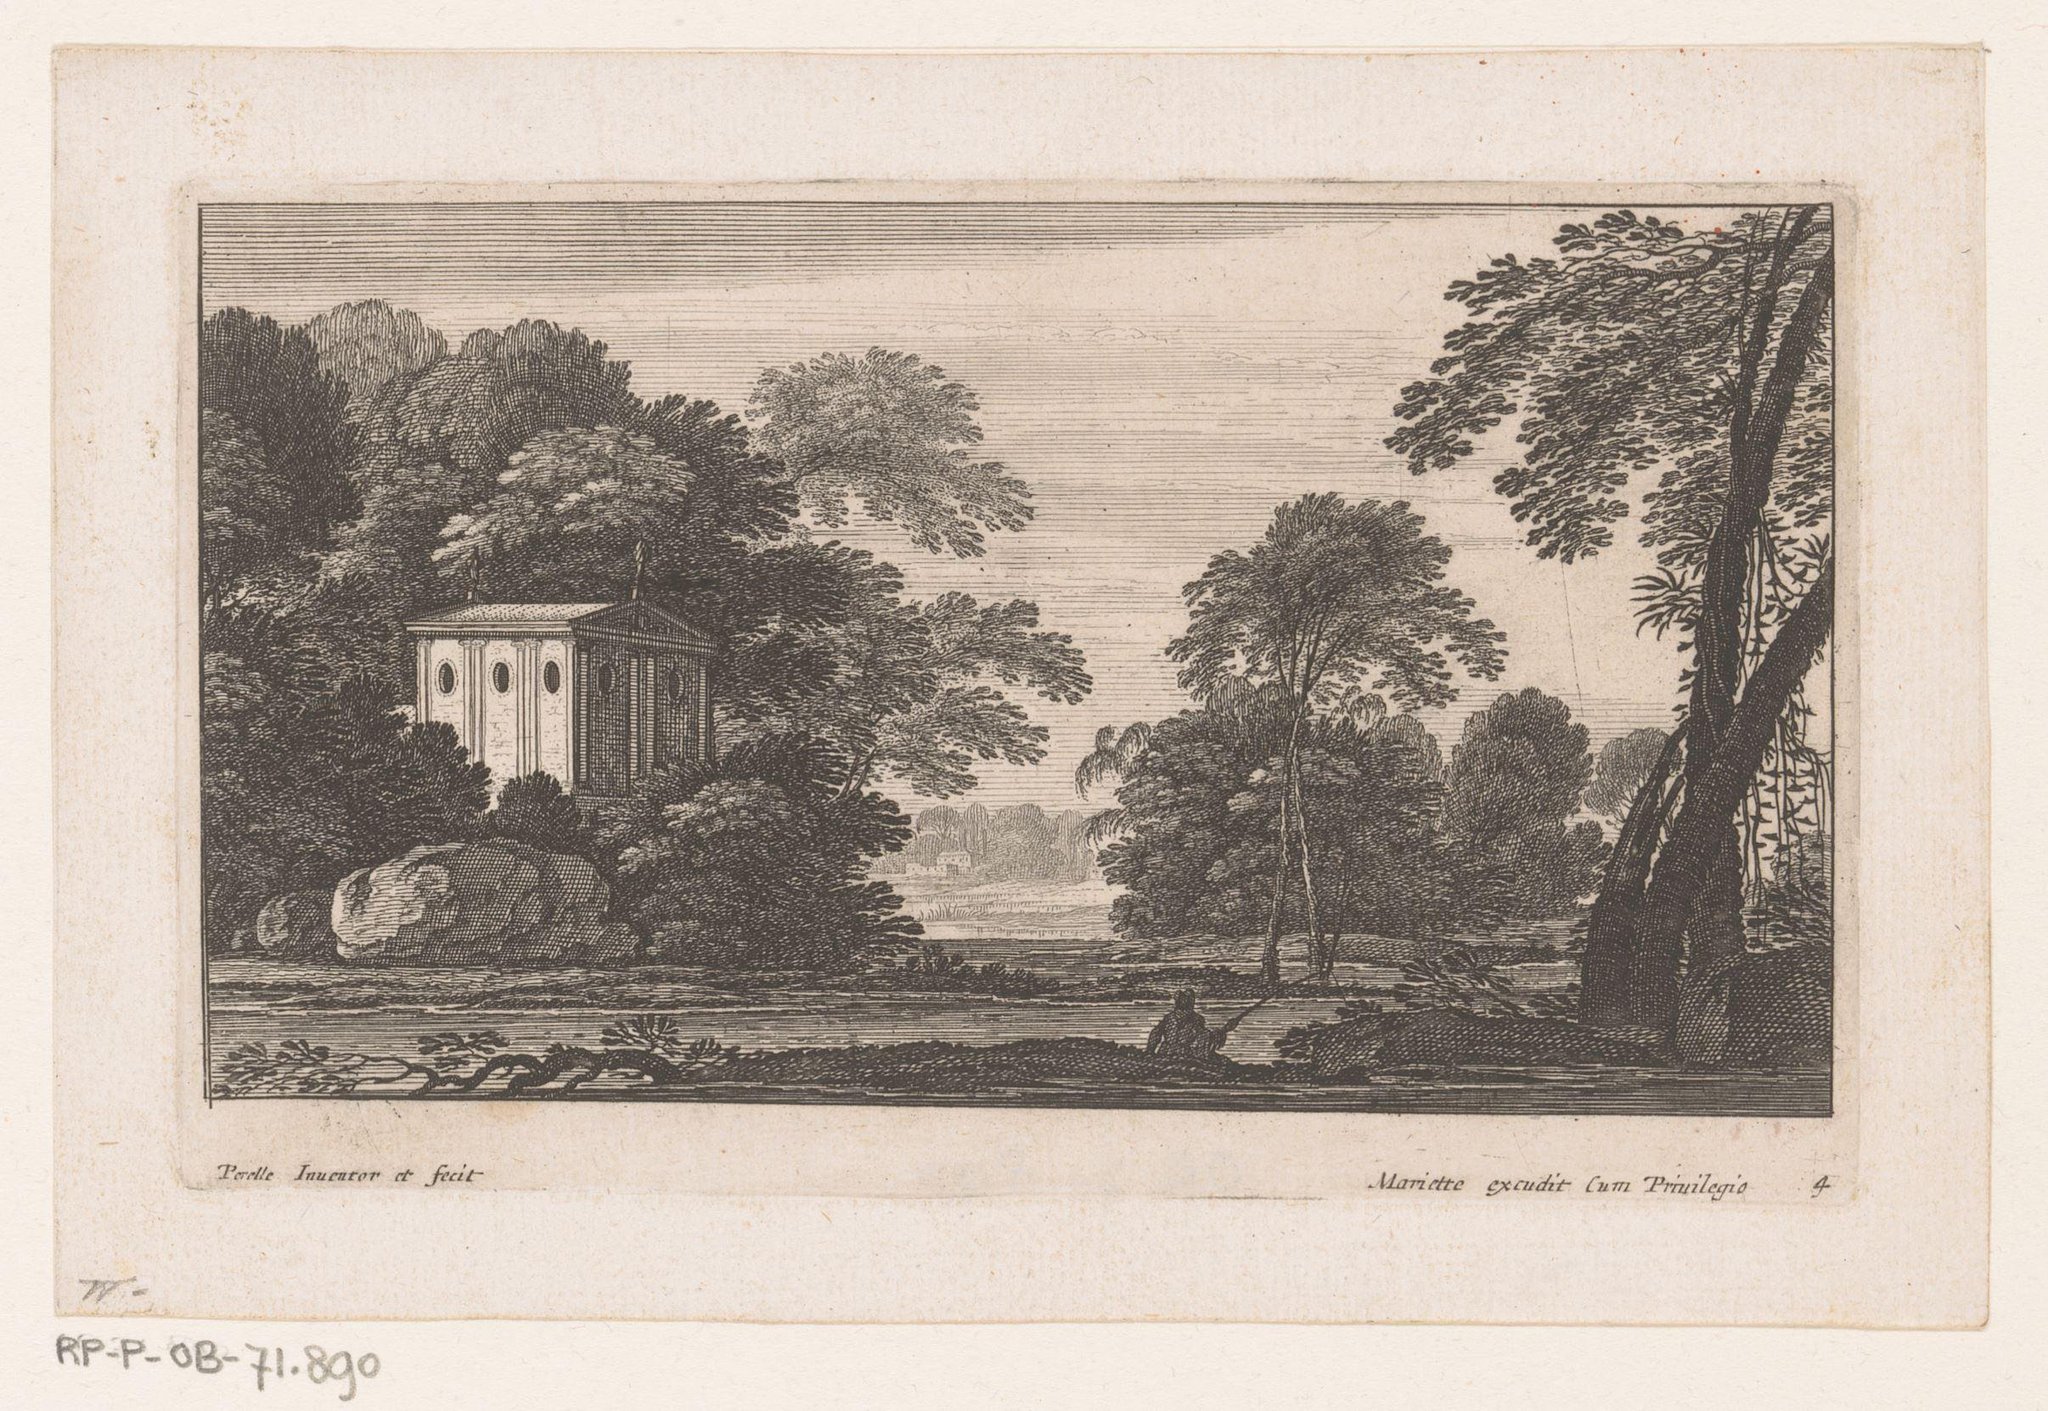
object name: print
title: Rivierlandschap met tempel en visser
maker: mariette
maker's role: publisher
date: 1613-1695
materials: paper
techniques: etching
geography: paris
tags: landscapes with waters, waterscapes, seascapes (in the temperate zone)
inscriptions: collector's mark: Lugt 240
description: Prenten met het signatuur 'Perelle' kunnen zowel door vader Gabriel als door zonen Nicolas en Adam gemaakt zijn.